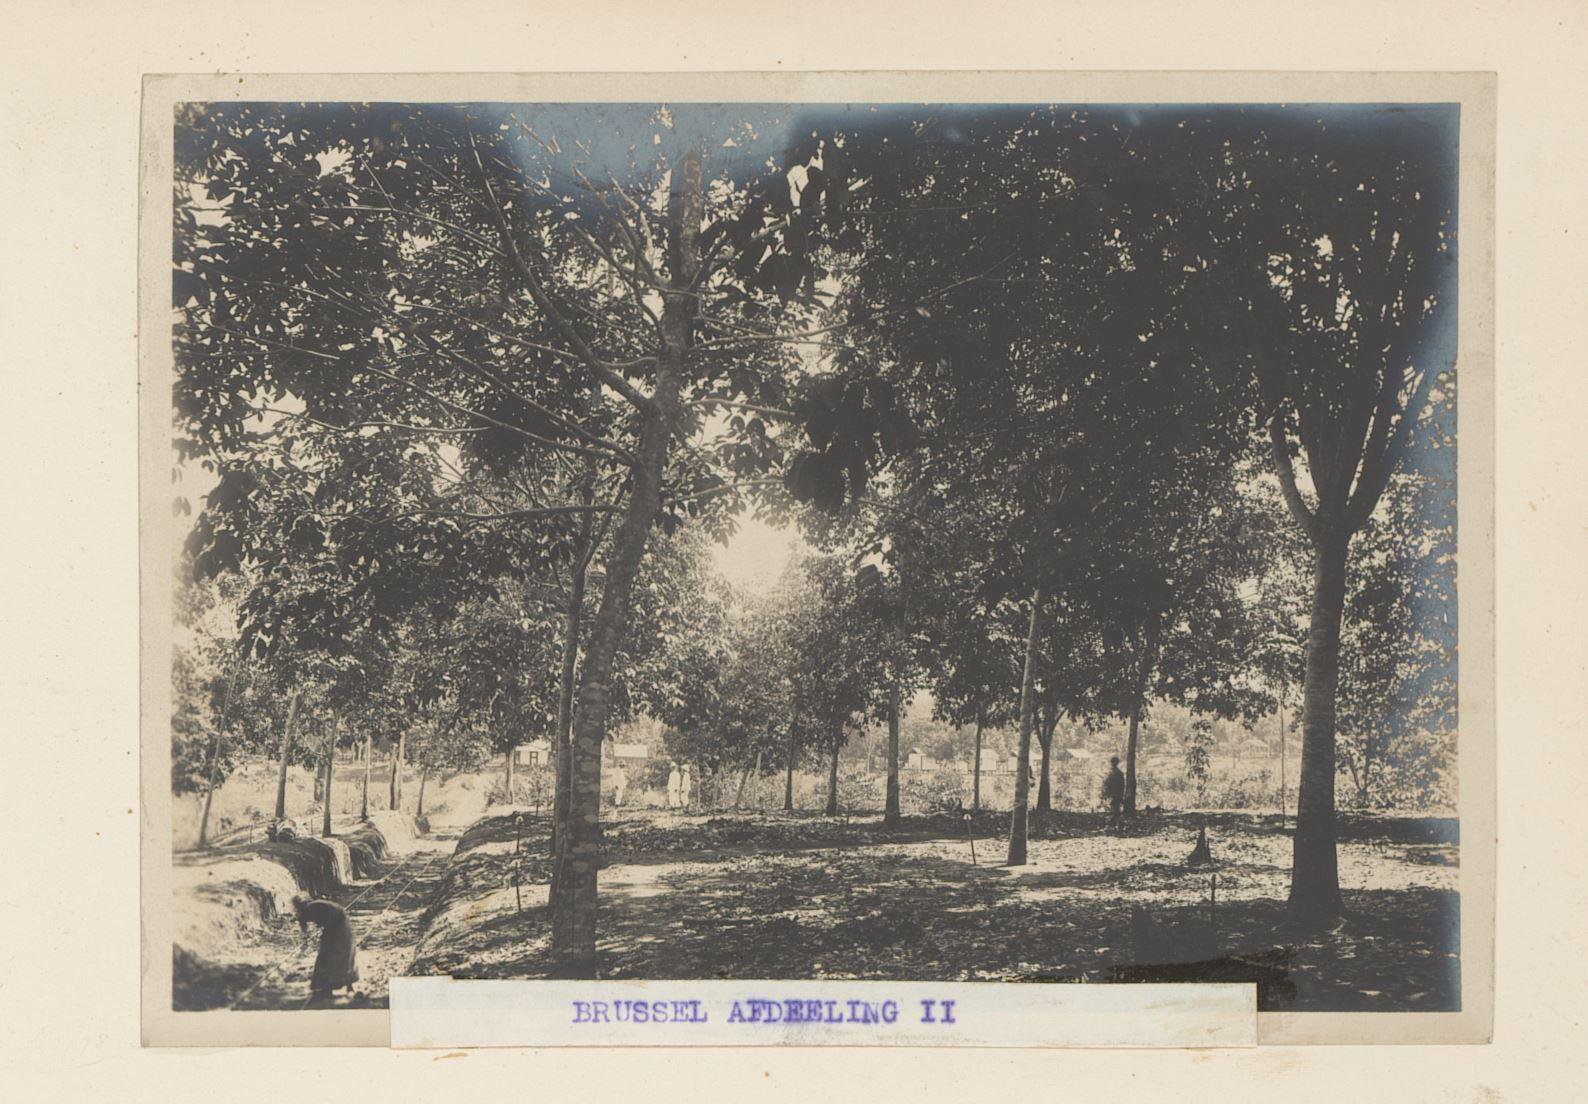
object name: photograph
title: Brussel Afdeeling II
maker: Anonymous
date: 1913-1924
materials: photographic support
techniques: gelatin silver print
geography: east sumatra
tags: plantation, (non-fruit) products of plants or trees: rubber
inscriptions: inscription: ‘Brussel Afdeeling II’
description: Rubberbomen in afdeling II van de plantage Brussel. Tussen de bomen staan enkele Europese mannen in witte pakken. Met etiket onder de foto. Onderdeel van het fotoalbum over de plantages Brussel en Pernantian van de Sumatra Caoutchouc Maatschappij op de Oostkust van Sumatra in de jaren 1910-1935.